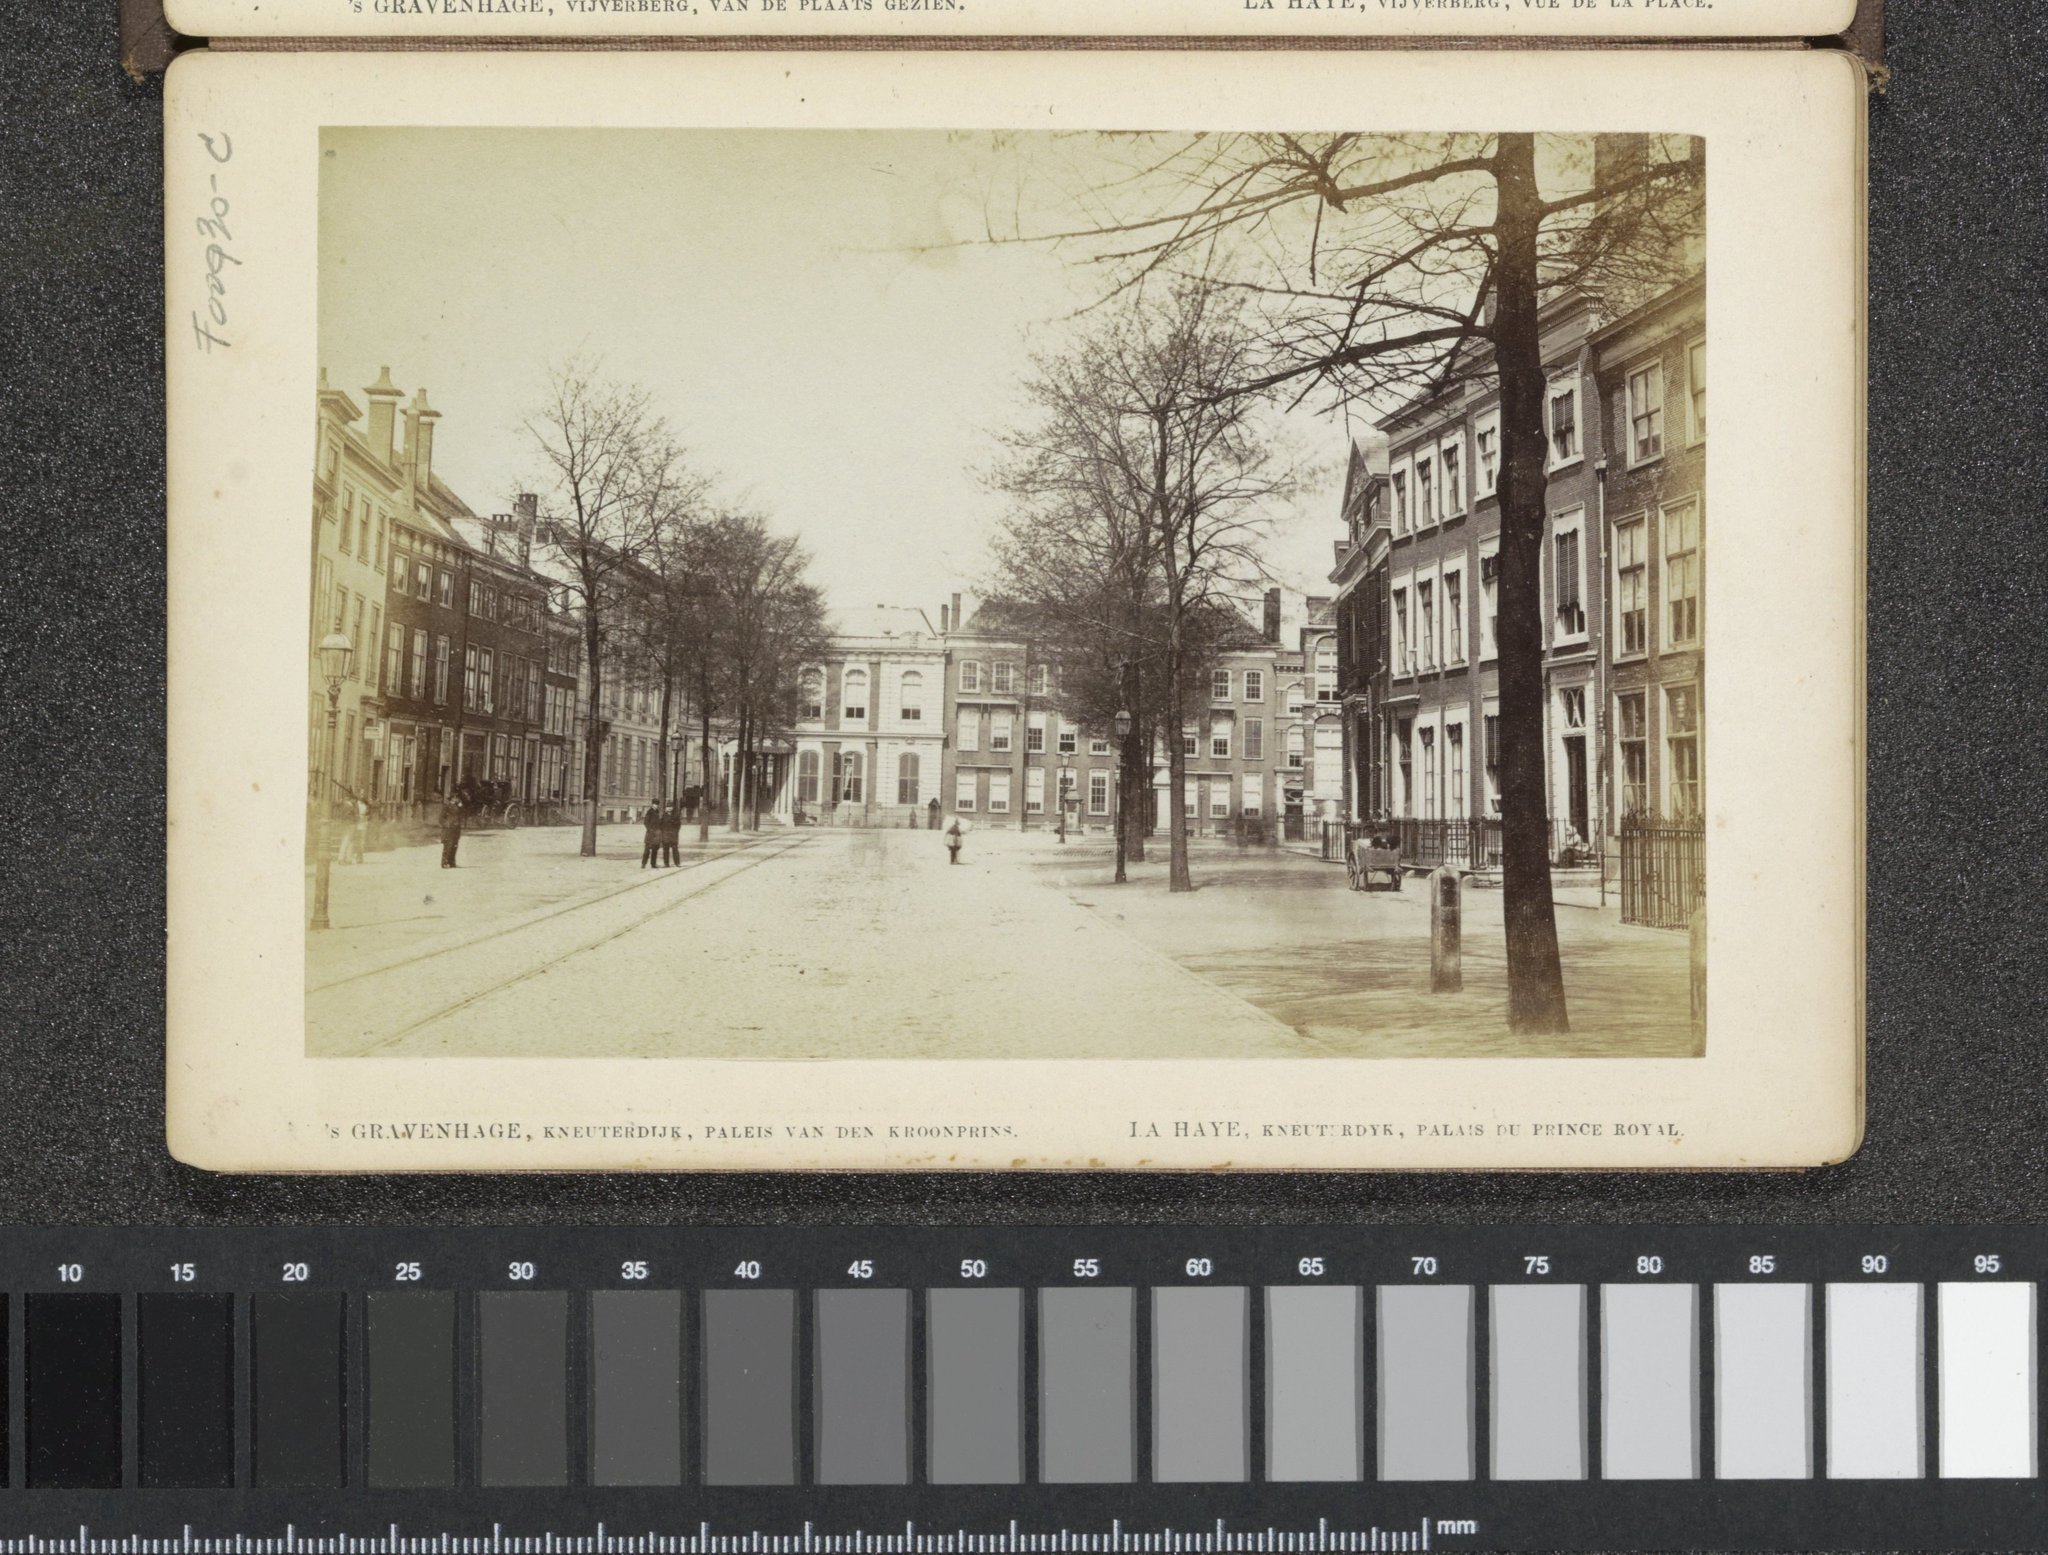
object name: cabinet photograph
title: 's Gravenhage, Kneuterdijk, paleis van den Kroonprins. La Haye, Kneuterdijk, palais du Prince Royal.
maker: andries jager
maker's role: publisher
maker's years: 1825-1905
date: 1865-1870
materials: cardboard, photographic support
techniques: albumen print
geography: the hague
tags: palace, street (+ city(-scape) with figures, staffage)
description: Onderdeel van Leporelloalbum met foto's van Den Haag.